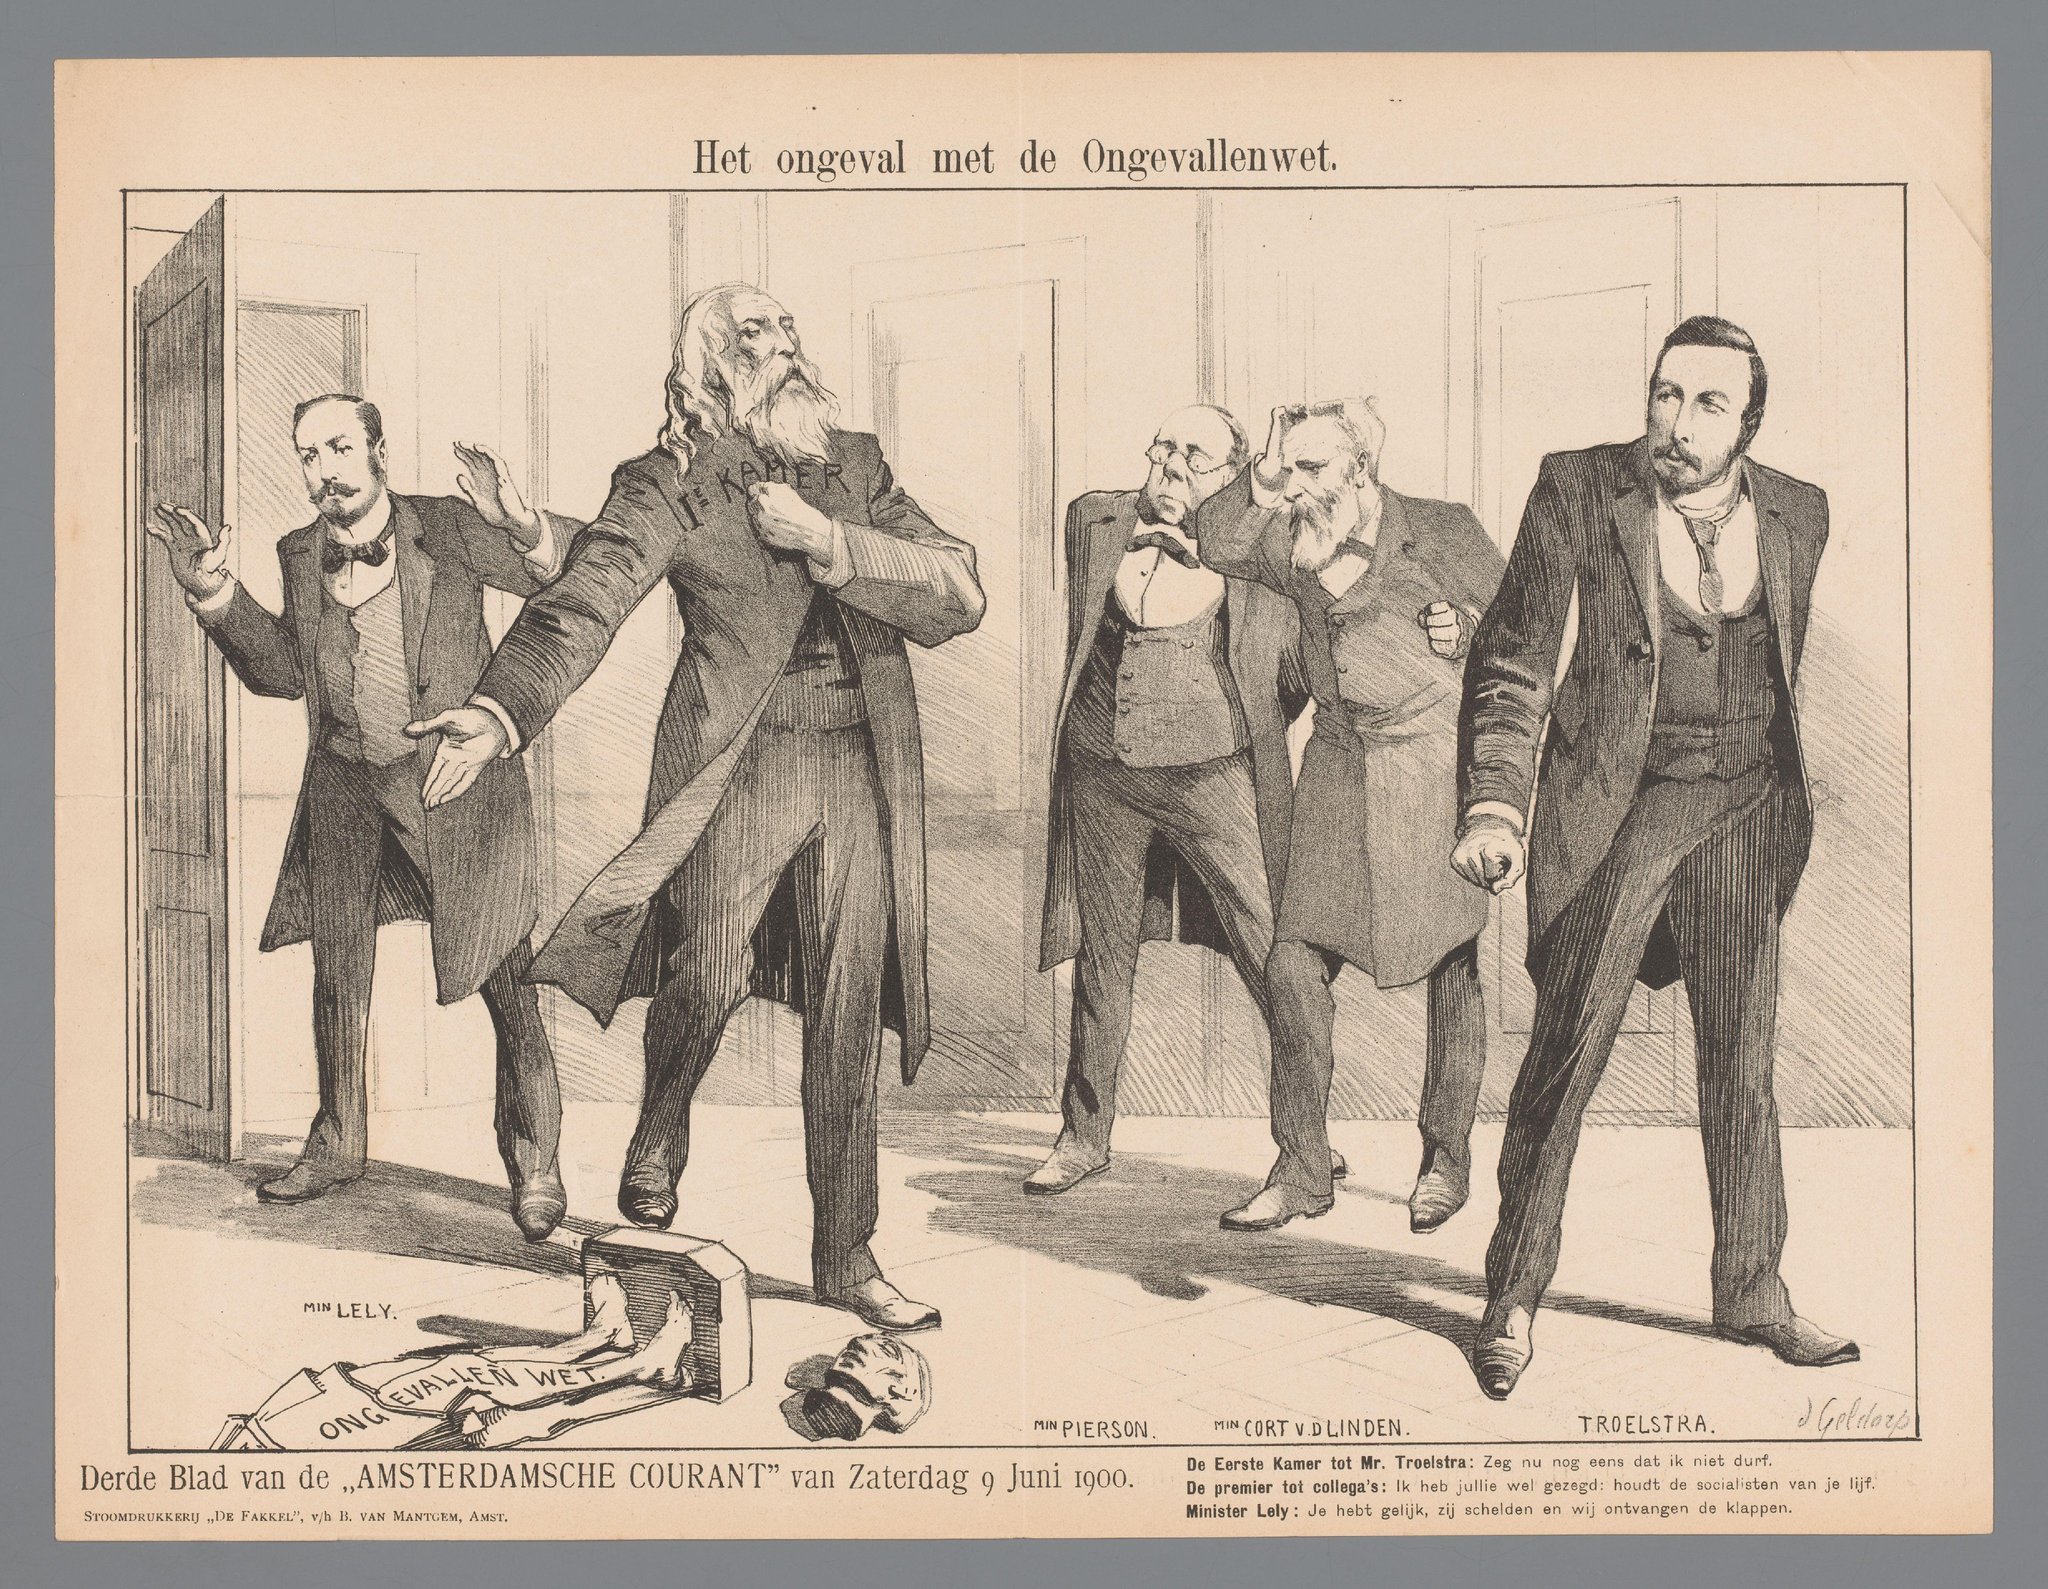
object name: cartoon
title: Het ongeval met de ongevallenwet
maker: petrus van geldorp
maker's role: draughtsman, print maker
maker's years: 1872-1939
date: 1900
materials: paper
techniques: lithograph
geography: amsterdam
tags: amsterdam, nicolaas gerard pierson, the hague, politician, historical persons, politician, e.g. party leader, political caricatures and satires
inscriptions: date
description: Prent uit het bijvoegsel van: De Amsterdamsche Courant, 9 juni 1900.